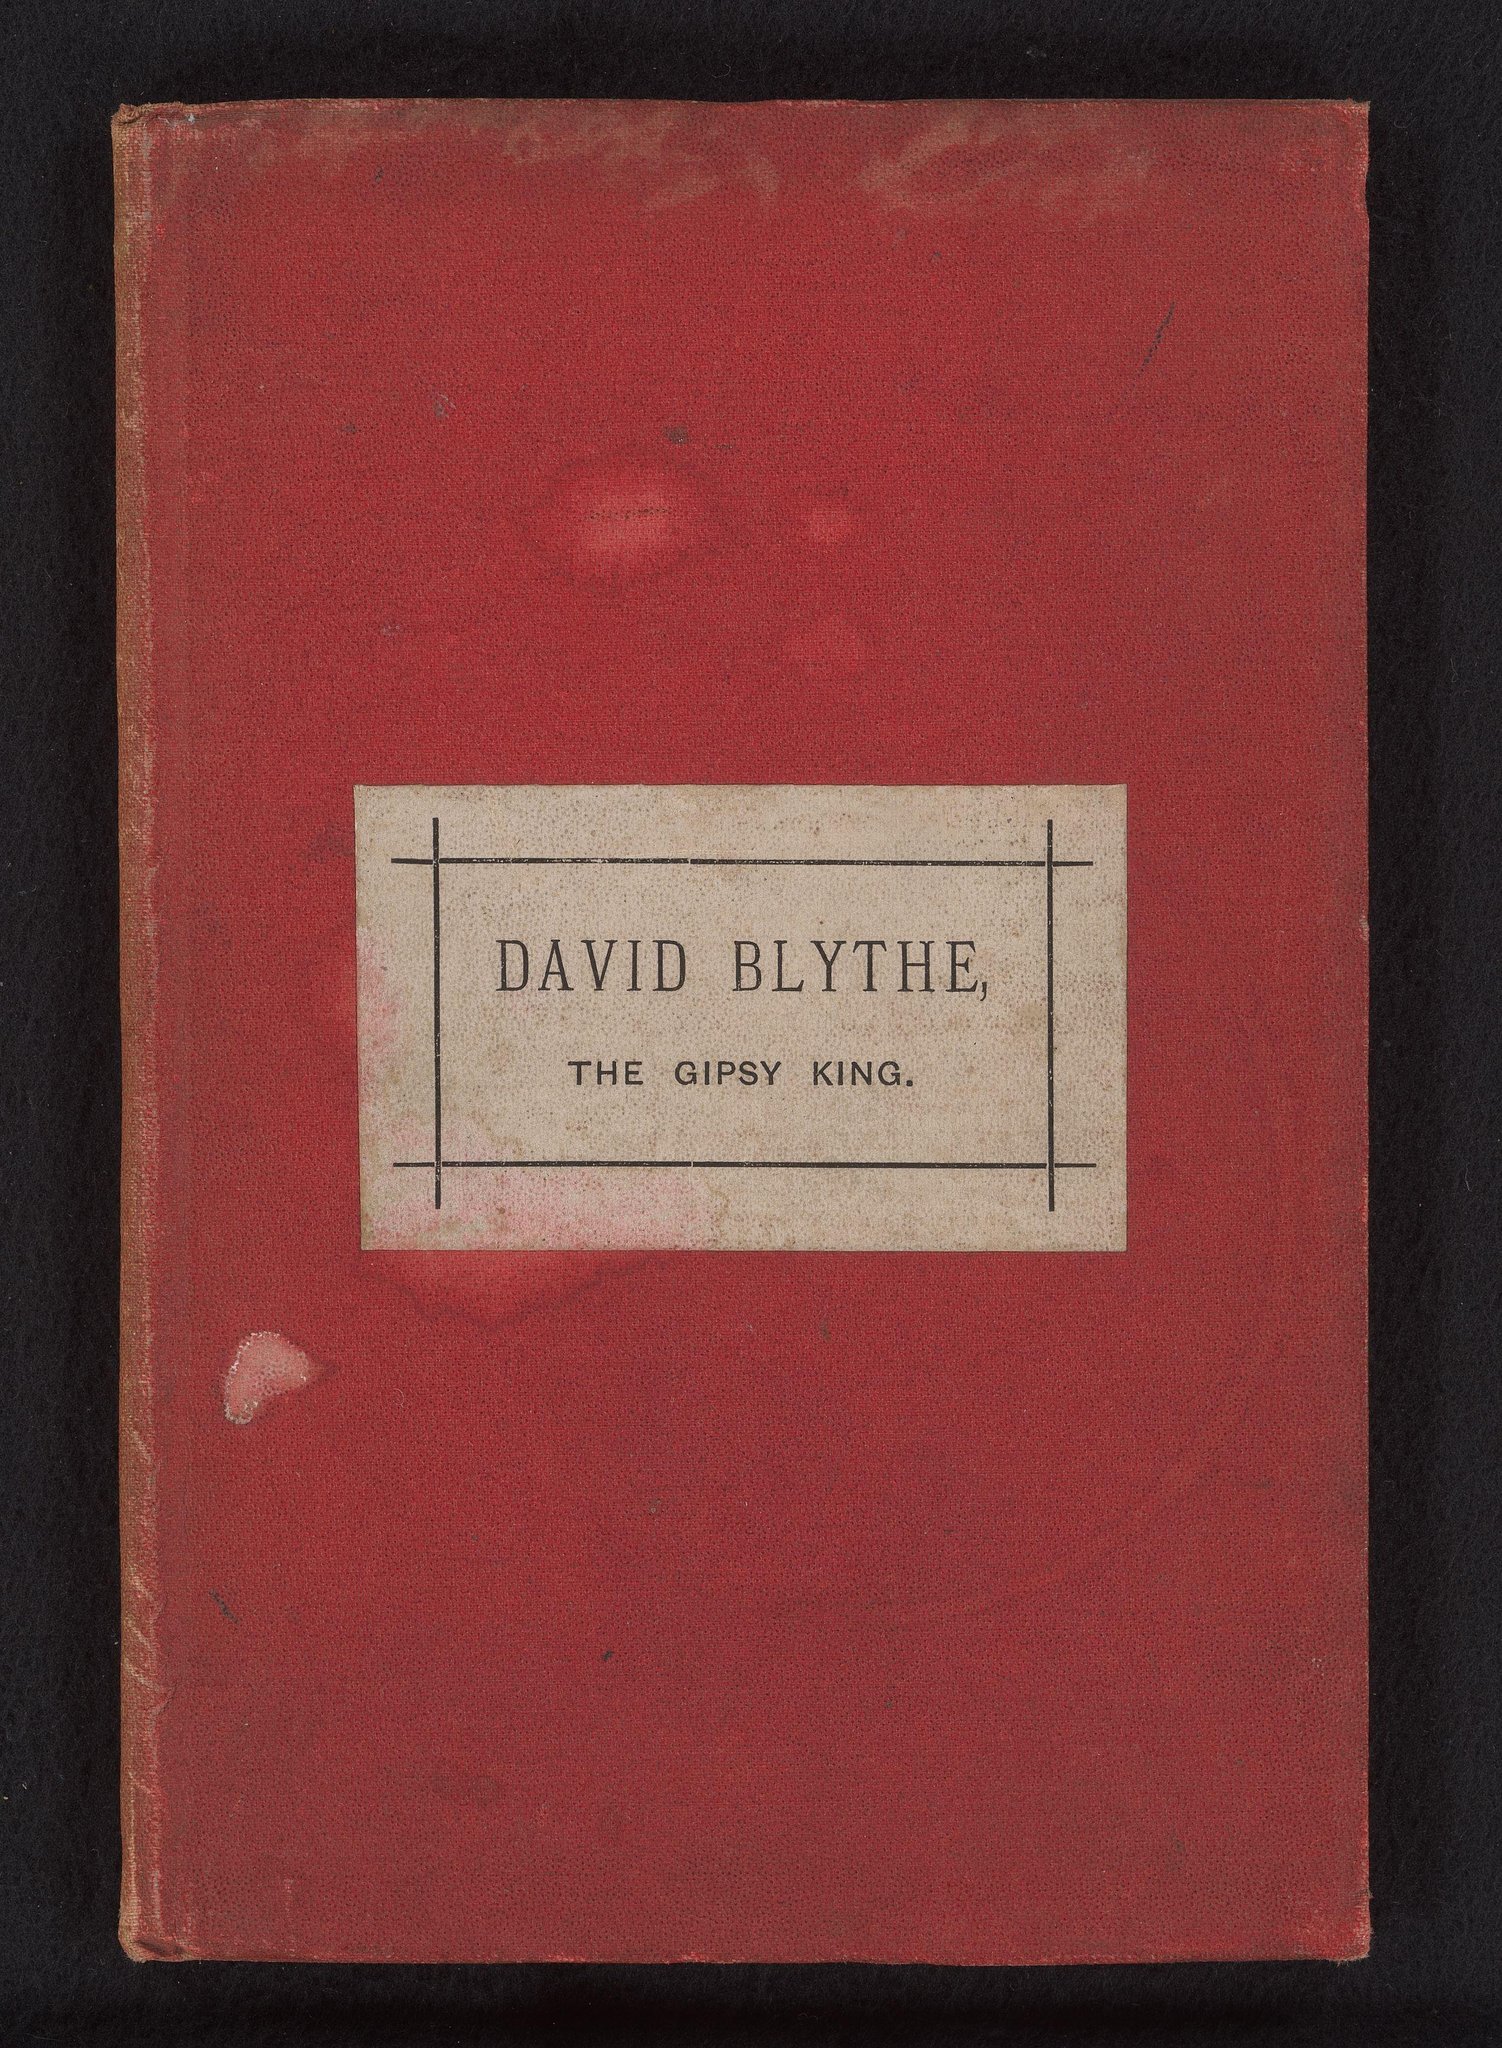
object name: book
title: David Blythe, the gypsy king : a character sketch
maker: charles stuart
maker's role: schrijver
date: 1883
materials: cardboard, linen, paper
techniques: decorated paper, letterpress printing, woodburytype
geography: kelso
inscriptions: inscription: ‘25’, inscription: ‘35=/ front, orig. photograph/ gypsies/ RARE!’